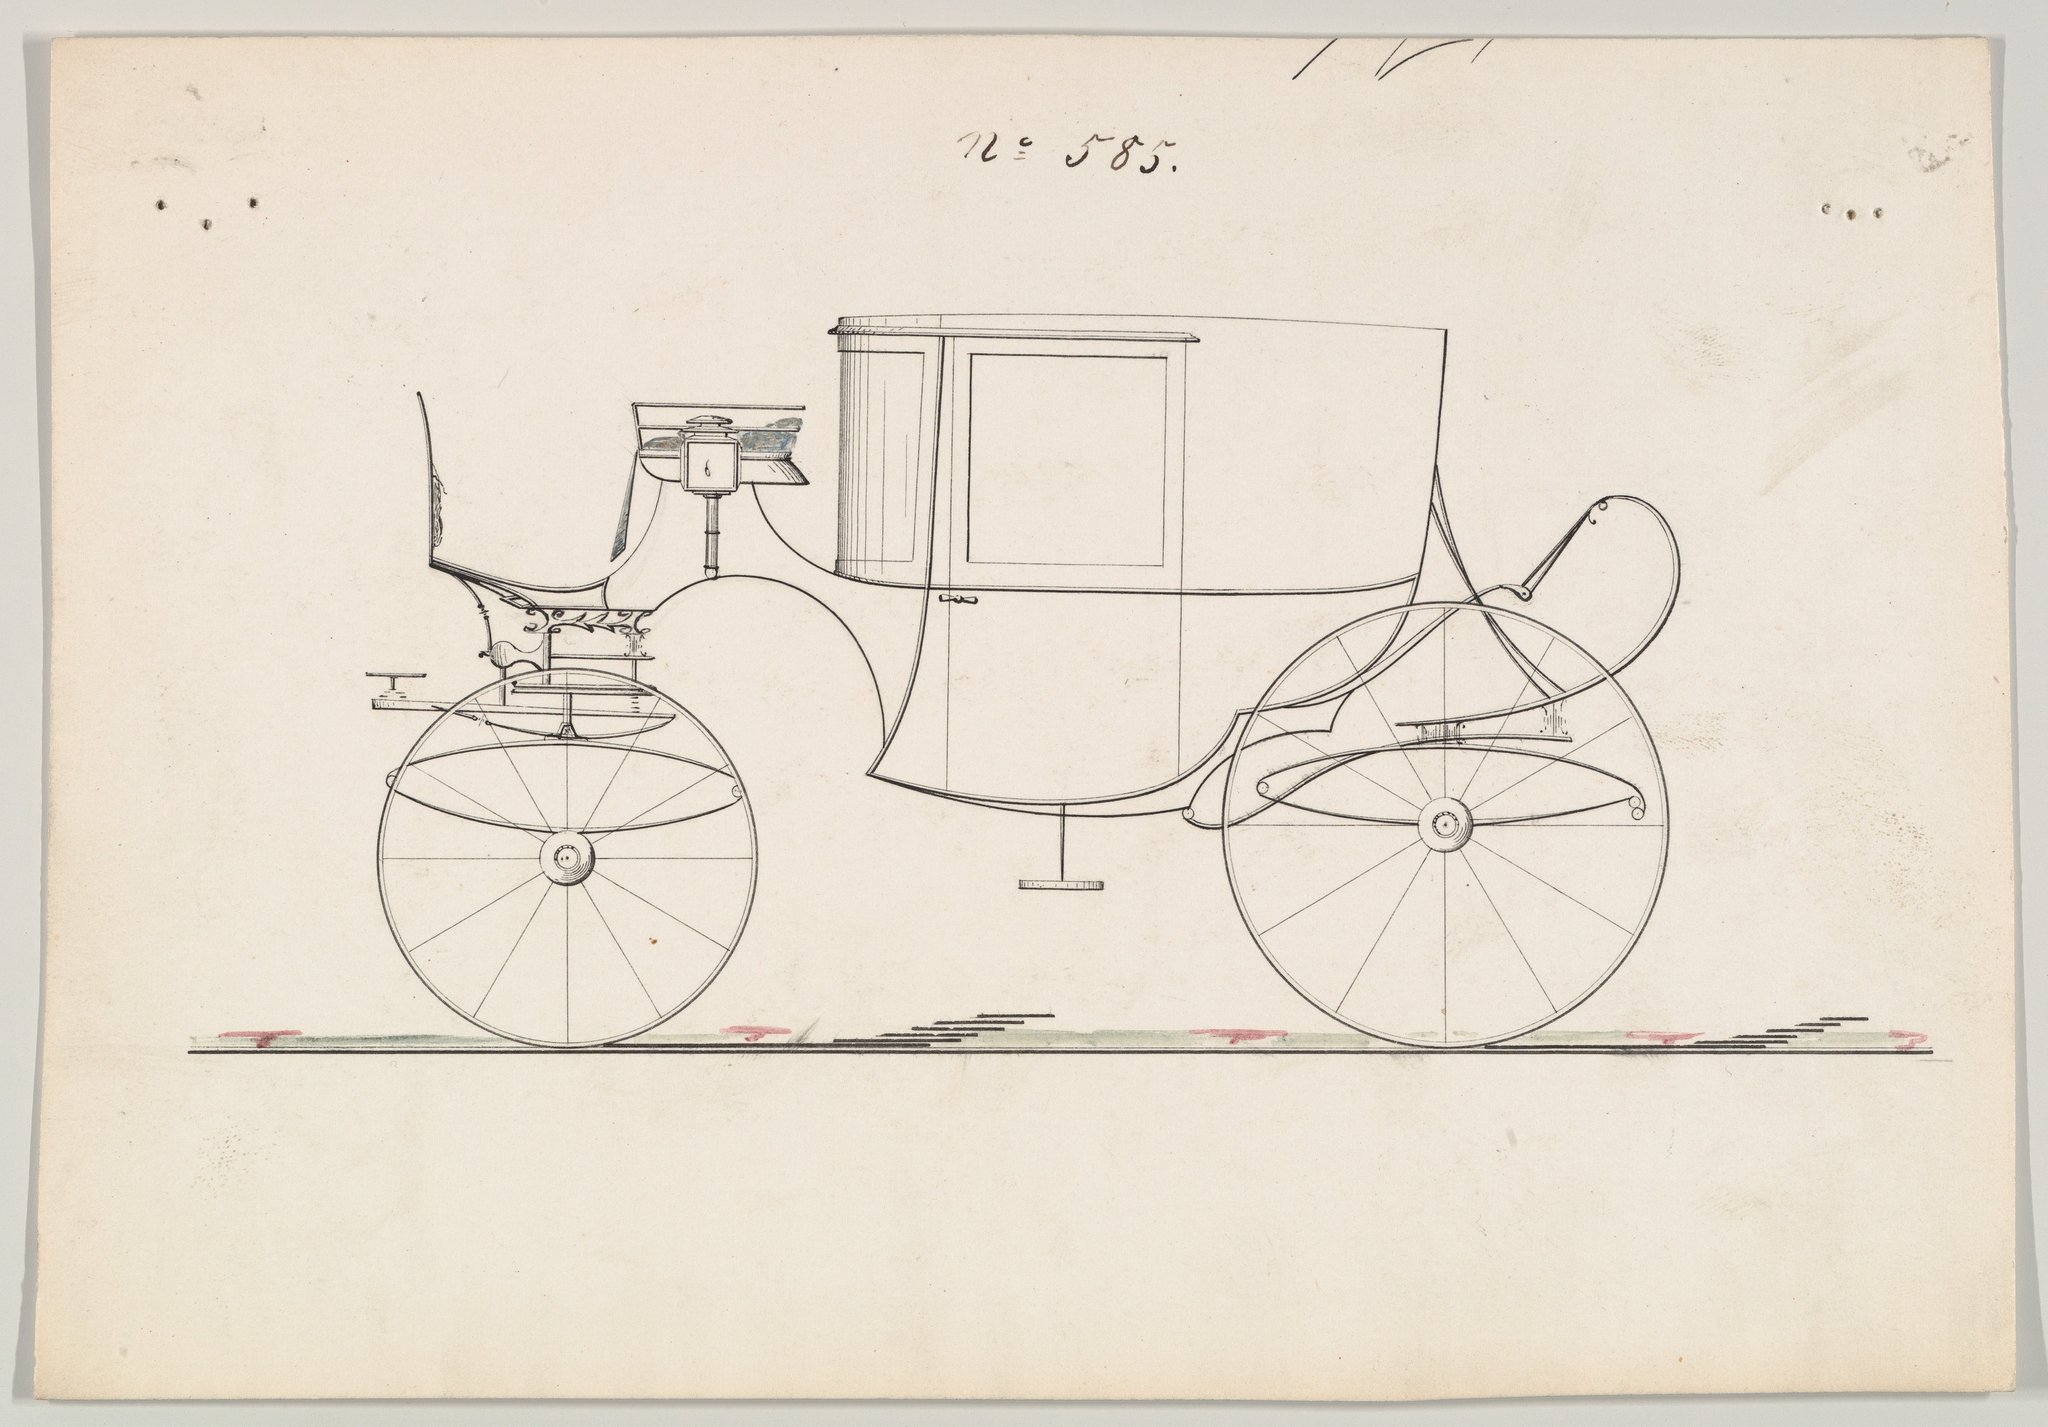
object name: drawing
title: Clarence #585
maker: brewster & co.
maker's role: manufacturer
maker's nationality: american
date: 1850-1870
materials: ink, watercolor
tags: carriages